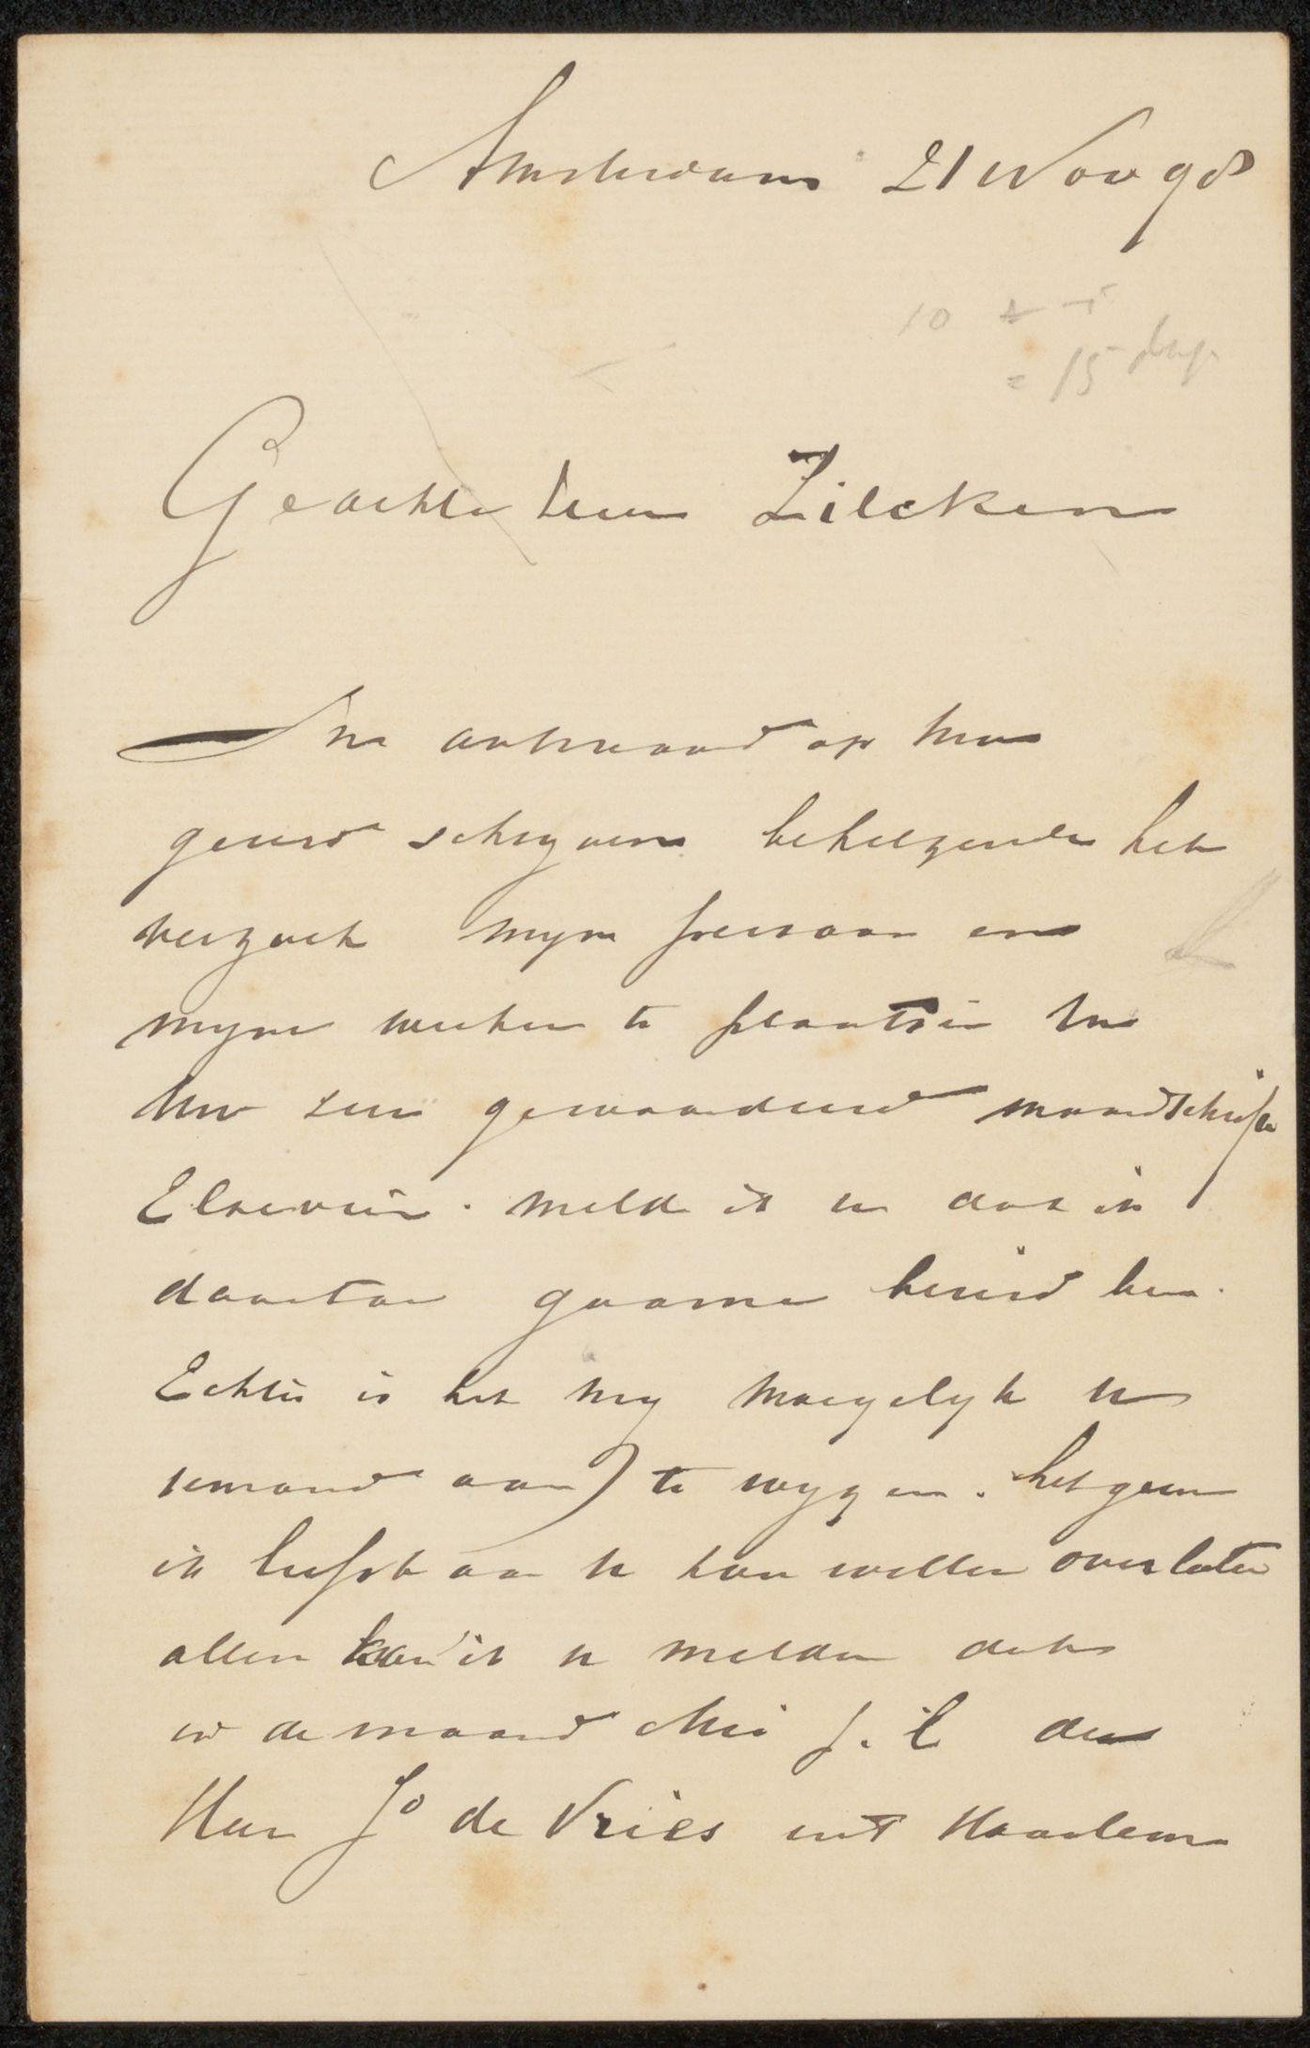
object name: letter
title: Brief aan Philip Zilcken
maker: bart van hove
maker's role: sculptor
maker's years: 1850-1914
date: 1898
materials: ink, paper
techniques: pen, writing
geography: amsterdam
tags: the hague, draughtsman, philip zilcken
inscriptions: collector's mark: ‘RPK’